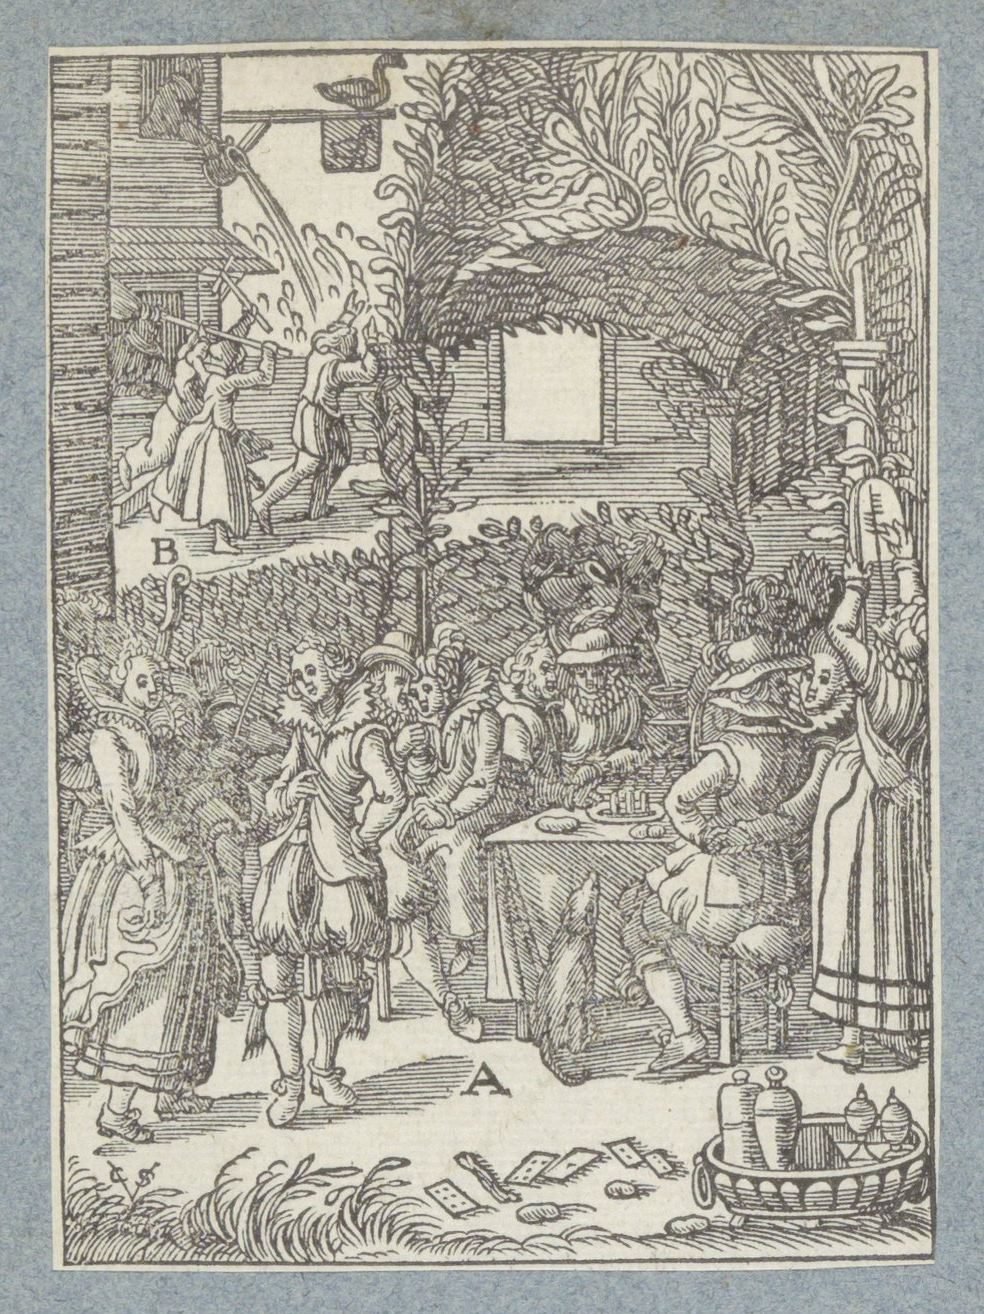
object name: print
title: Verloren zoon verkwist zijn erfenis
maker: pieter jacobsz. paets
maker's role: publisher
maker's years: 1587-1667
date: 1629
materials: paper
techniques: letterpress printing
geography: amsterdam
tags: tally, one pair dancing; man and woman dancing as a couple, pergola, private festivities, merry company - aa - in the open air, 'fête champêtre', the prodigal son in the midst of prostitutes feasting and dissipating his patrimony, usually in a brothel or inn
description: De verloren zoon verspilt zijn erfenis bij de dames van lichte zeden. Hij laat zich in een lusthof vermaken met muziek en welwillende dames. Op de voorgrond danst hij met een vrouw. Op de grond liggen speelkaarten en rechts houdt een vrouw de kerfstok bij. Op de achtergrond wordt de verloren zoon, nadat het geld op is, de herberg of het bordeel uitgejaagd. Bij verschillende elementen uit de voorstelling staan letters. De voorstelling is hier mogelijk gebruikt als afbeelding van het feestend en zondig volk van Nineve. De prent maakt deel uit van een album.